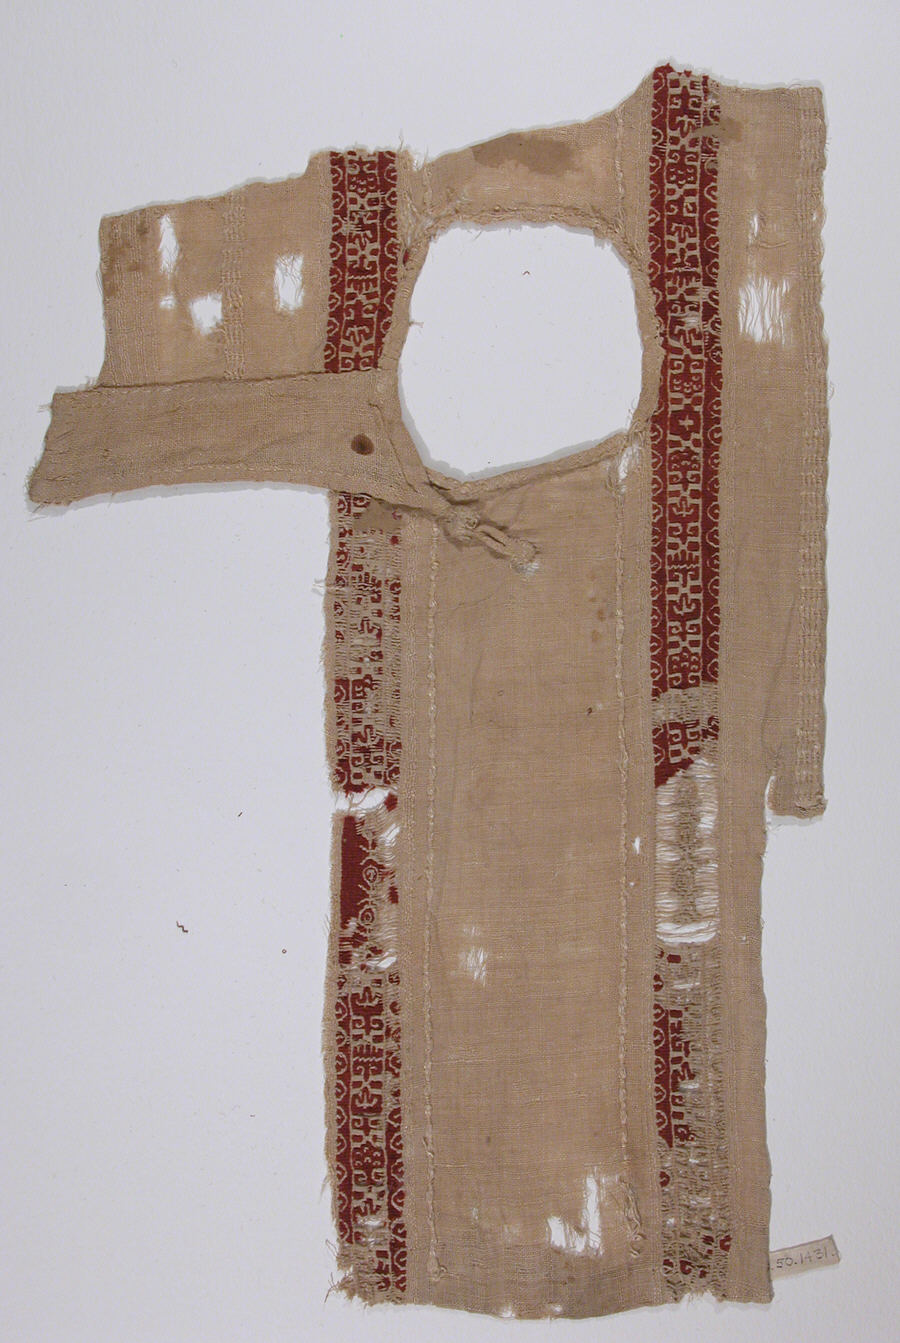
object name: tunic fragment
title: Tunic Fragment with Button Closure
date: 401-800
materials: linen, wool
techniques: weave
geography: egypt